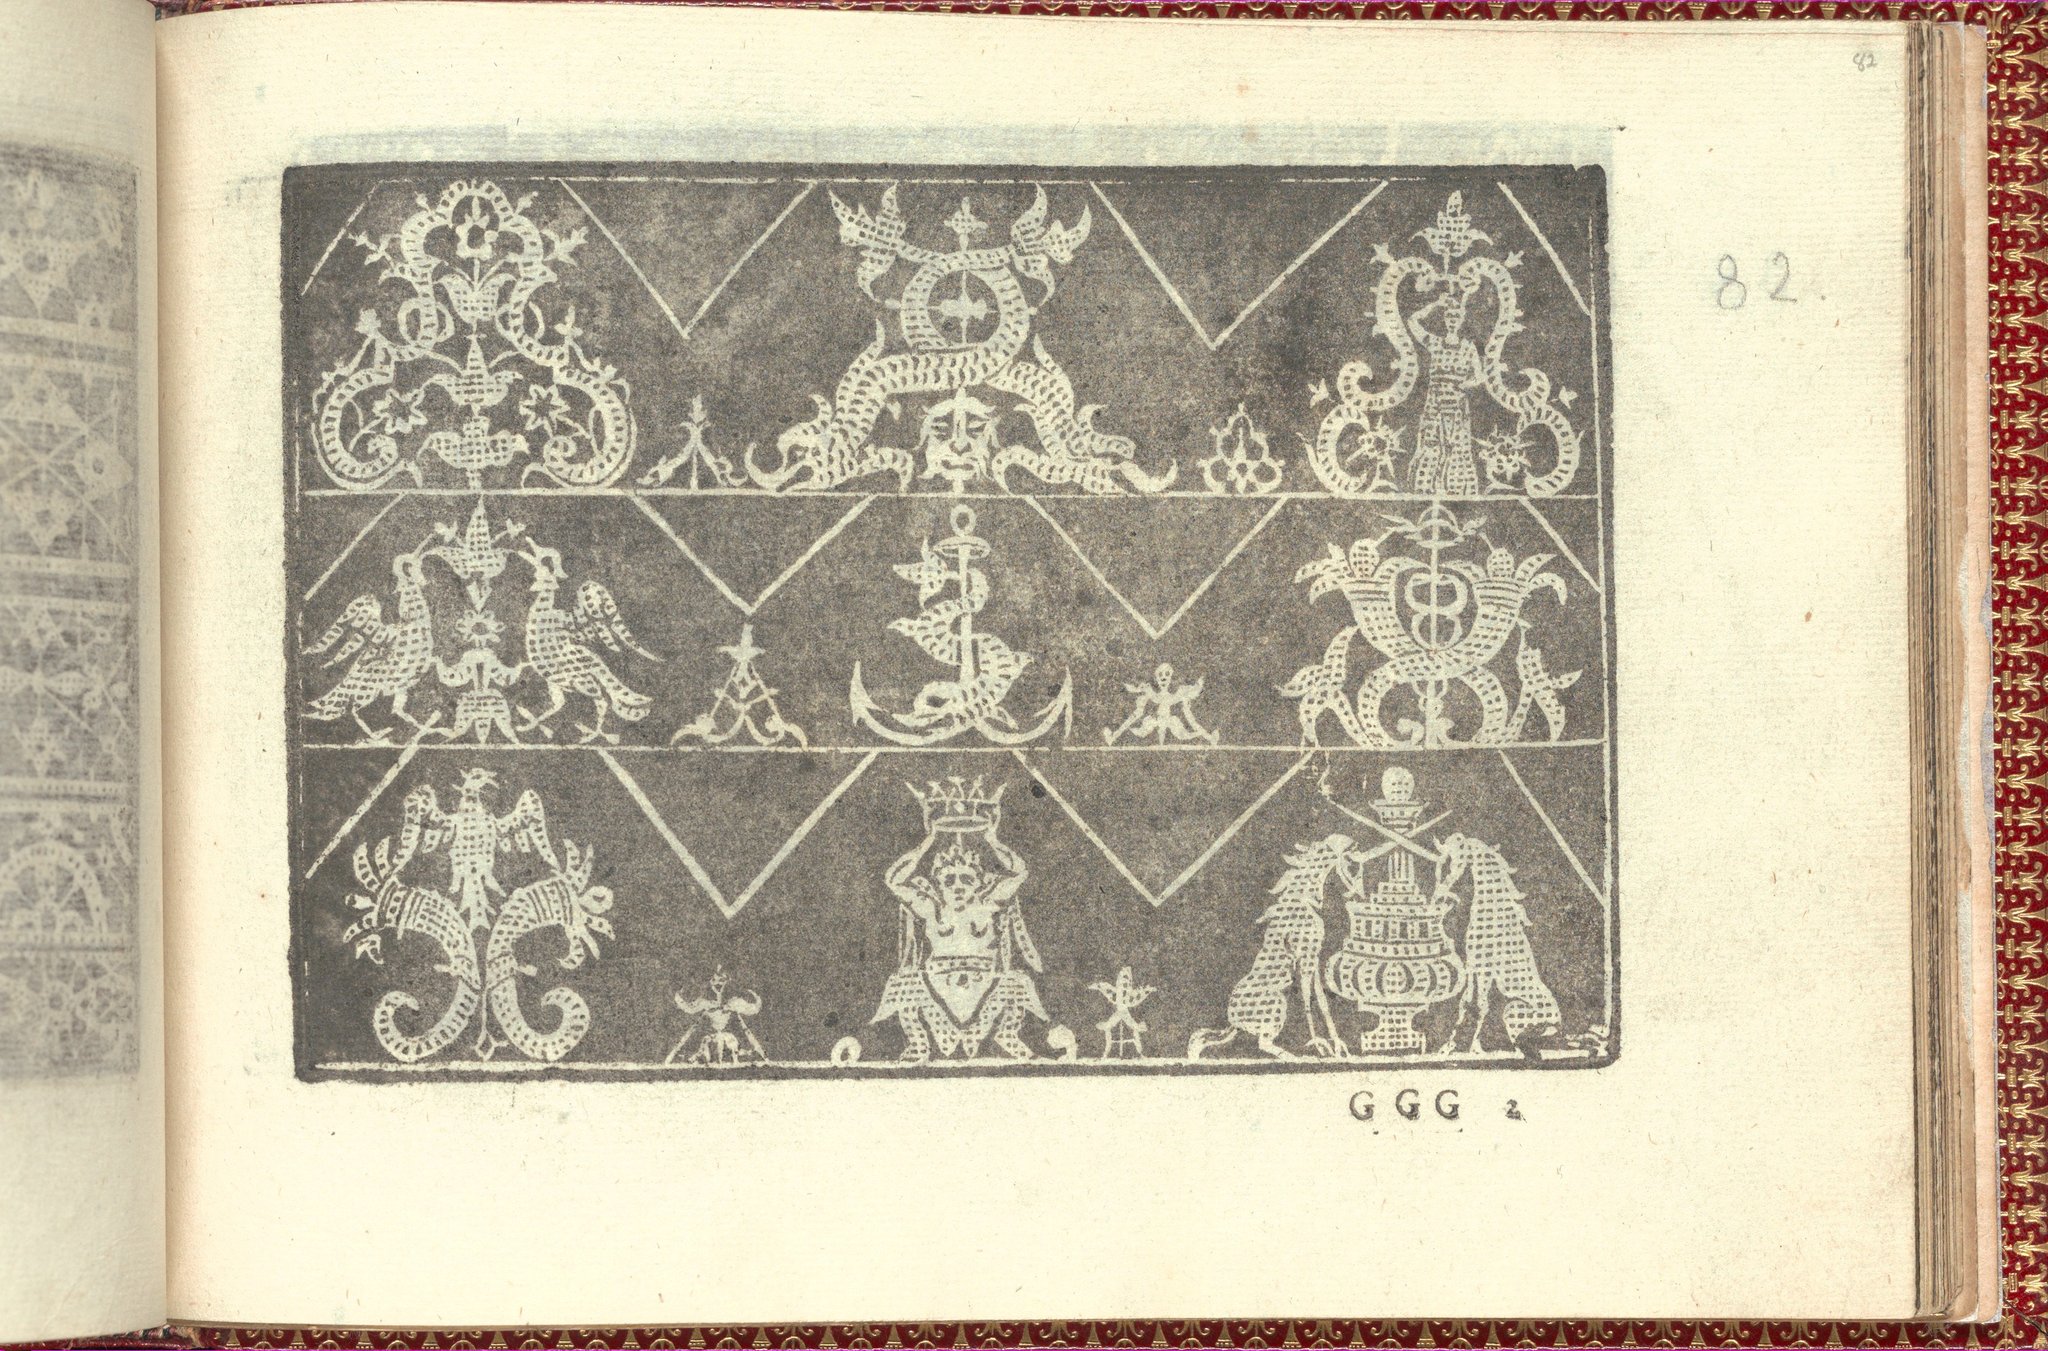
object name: book print ornament architecture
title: Corona delle Nobili et Virtuose Donne: Libro I-IV, page 82 (recto)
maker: cesare vecellio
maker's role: publisher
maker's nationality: italian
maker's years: 1521-1601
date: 1601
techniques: woodcut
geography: italy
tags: birds,unicorns,cornucopia,coat of arms